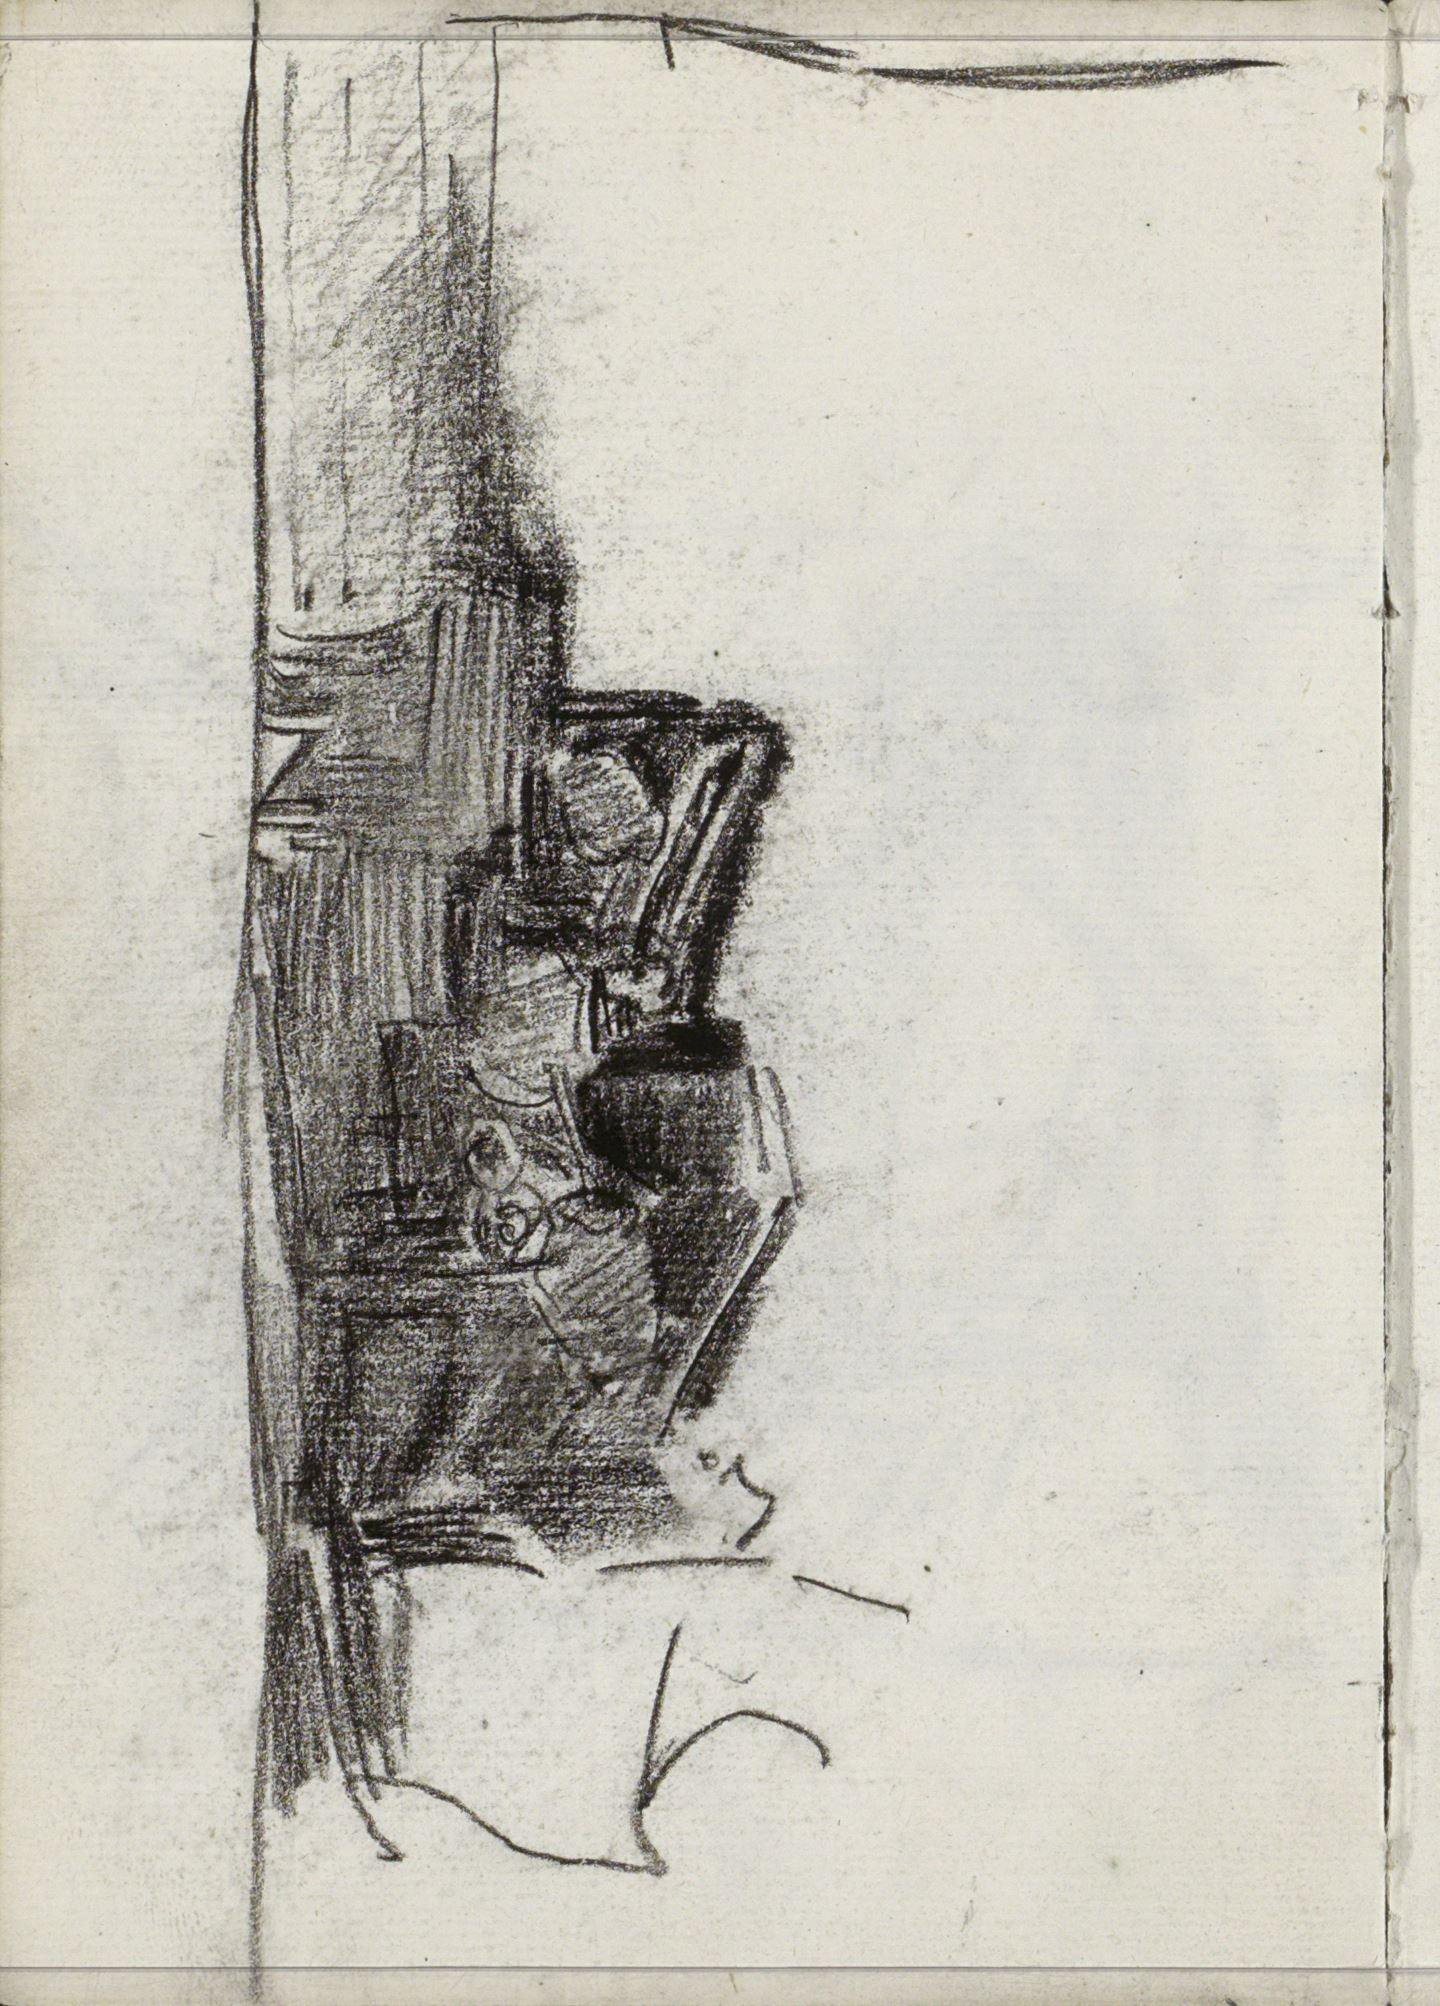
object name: sketchbook leaf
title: Studie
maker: isaac israels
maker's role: draughtsman, painter, print maker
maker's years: 1865-1934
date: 1886-1903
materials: chalk, paper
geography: amsterdam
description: Pagina 12 uit schetsboek XXXVII met 52 pagina's.